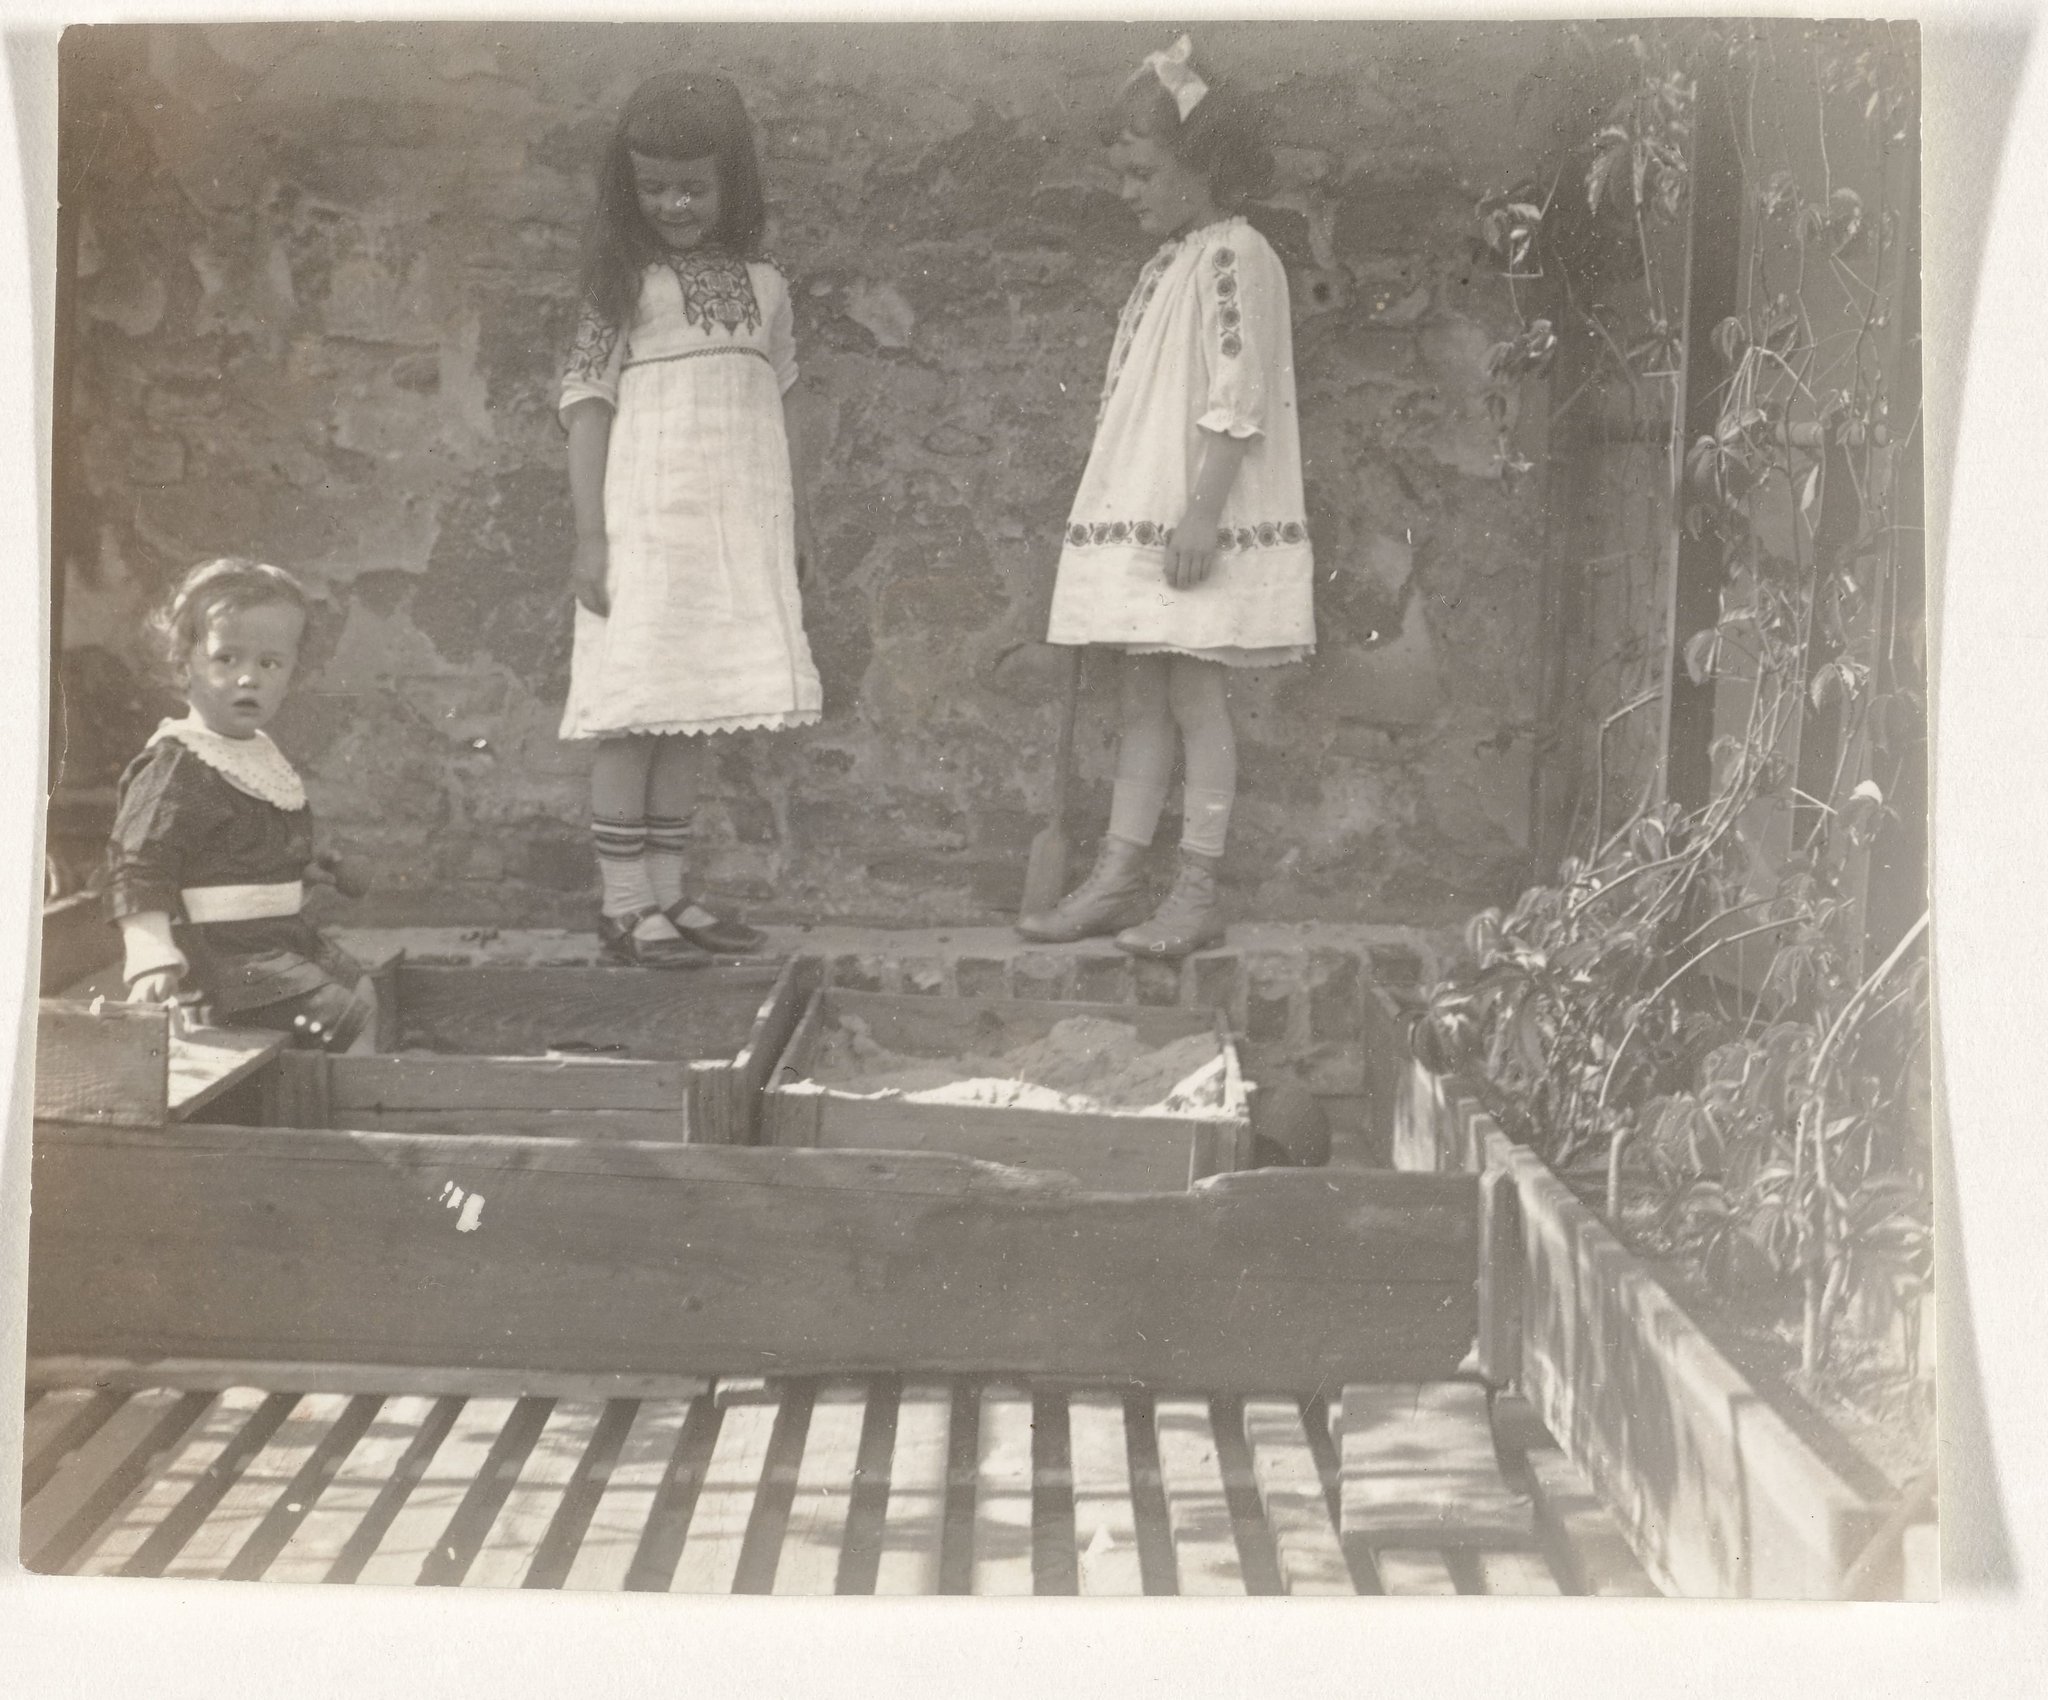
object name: photograph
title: Marba en Eckart Titzenthaler, kinderen van de fotograaf, en een onbekend meisje op het dakterras van het woonhuis in de Friedrichstrasse, Berlijn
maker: waldemar titzenthaler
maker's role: fotograaf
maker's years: 1869-1937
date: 1916-1917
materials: paper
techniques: gelatin silver print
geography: berlin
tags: engineer, girl (child between toddler and youth), tot, toddler ~ the ages of man, berlin